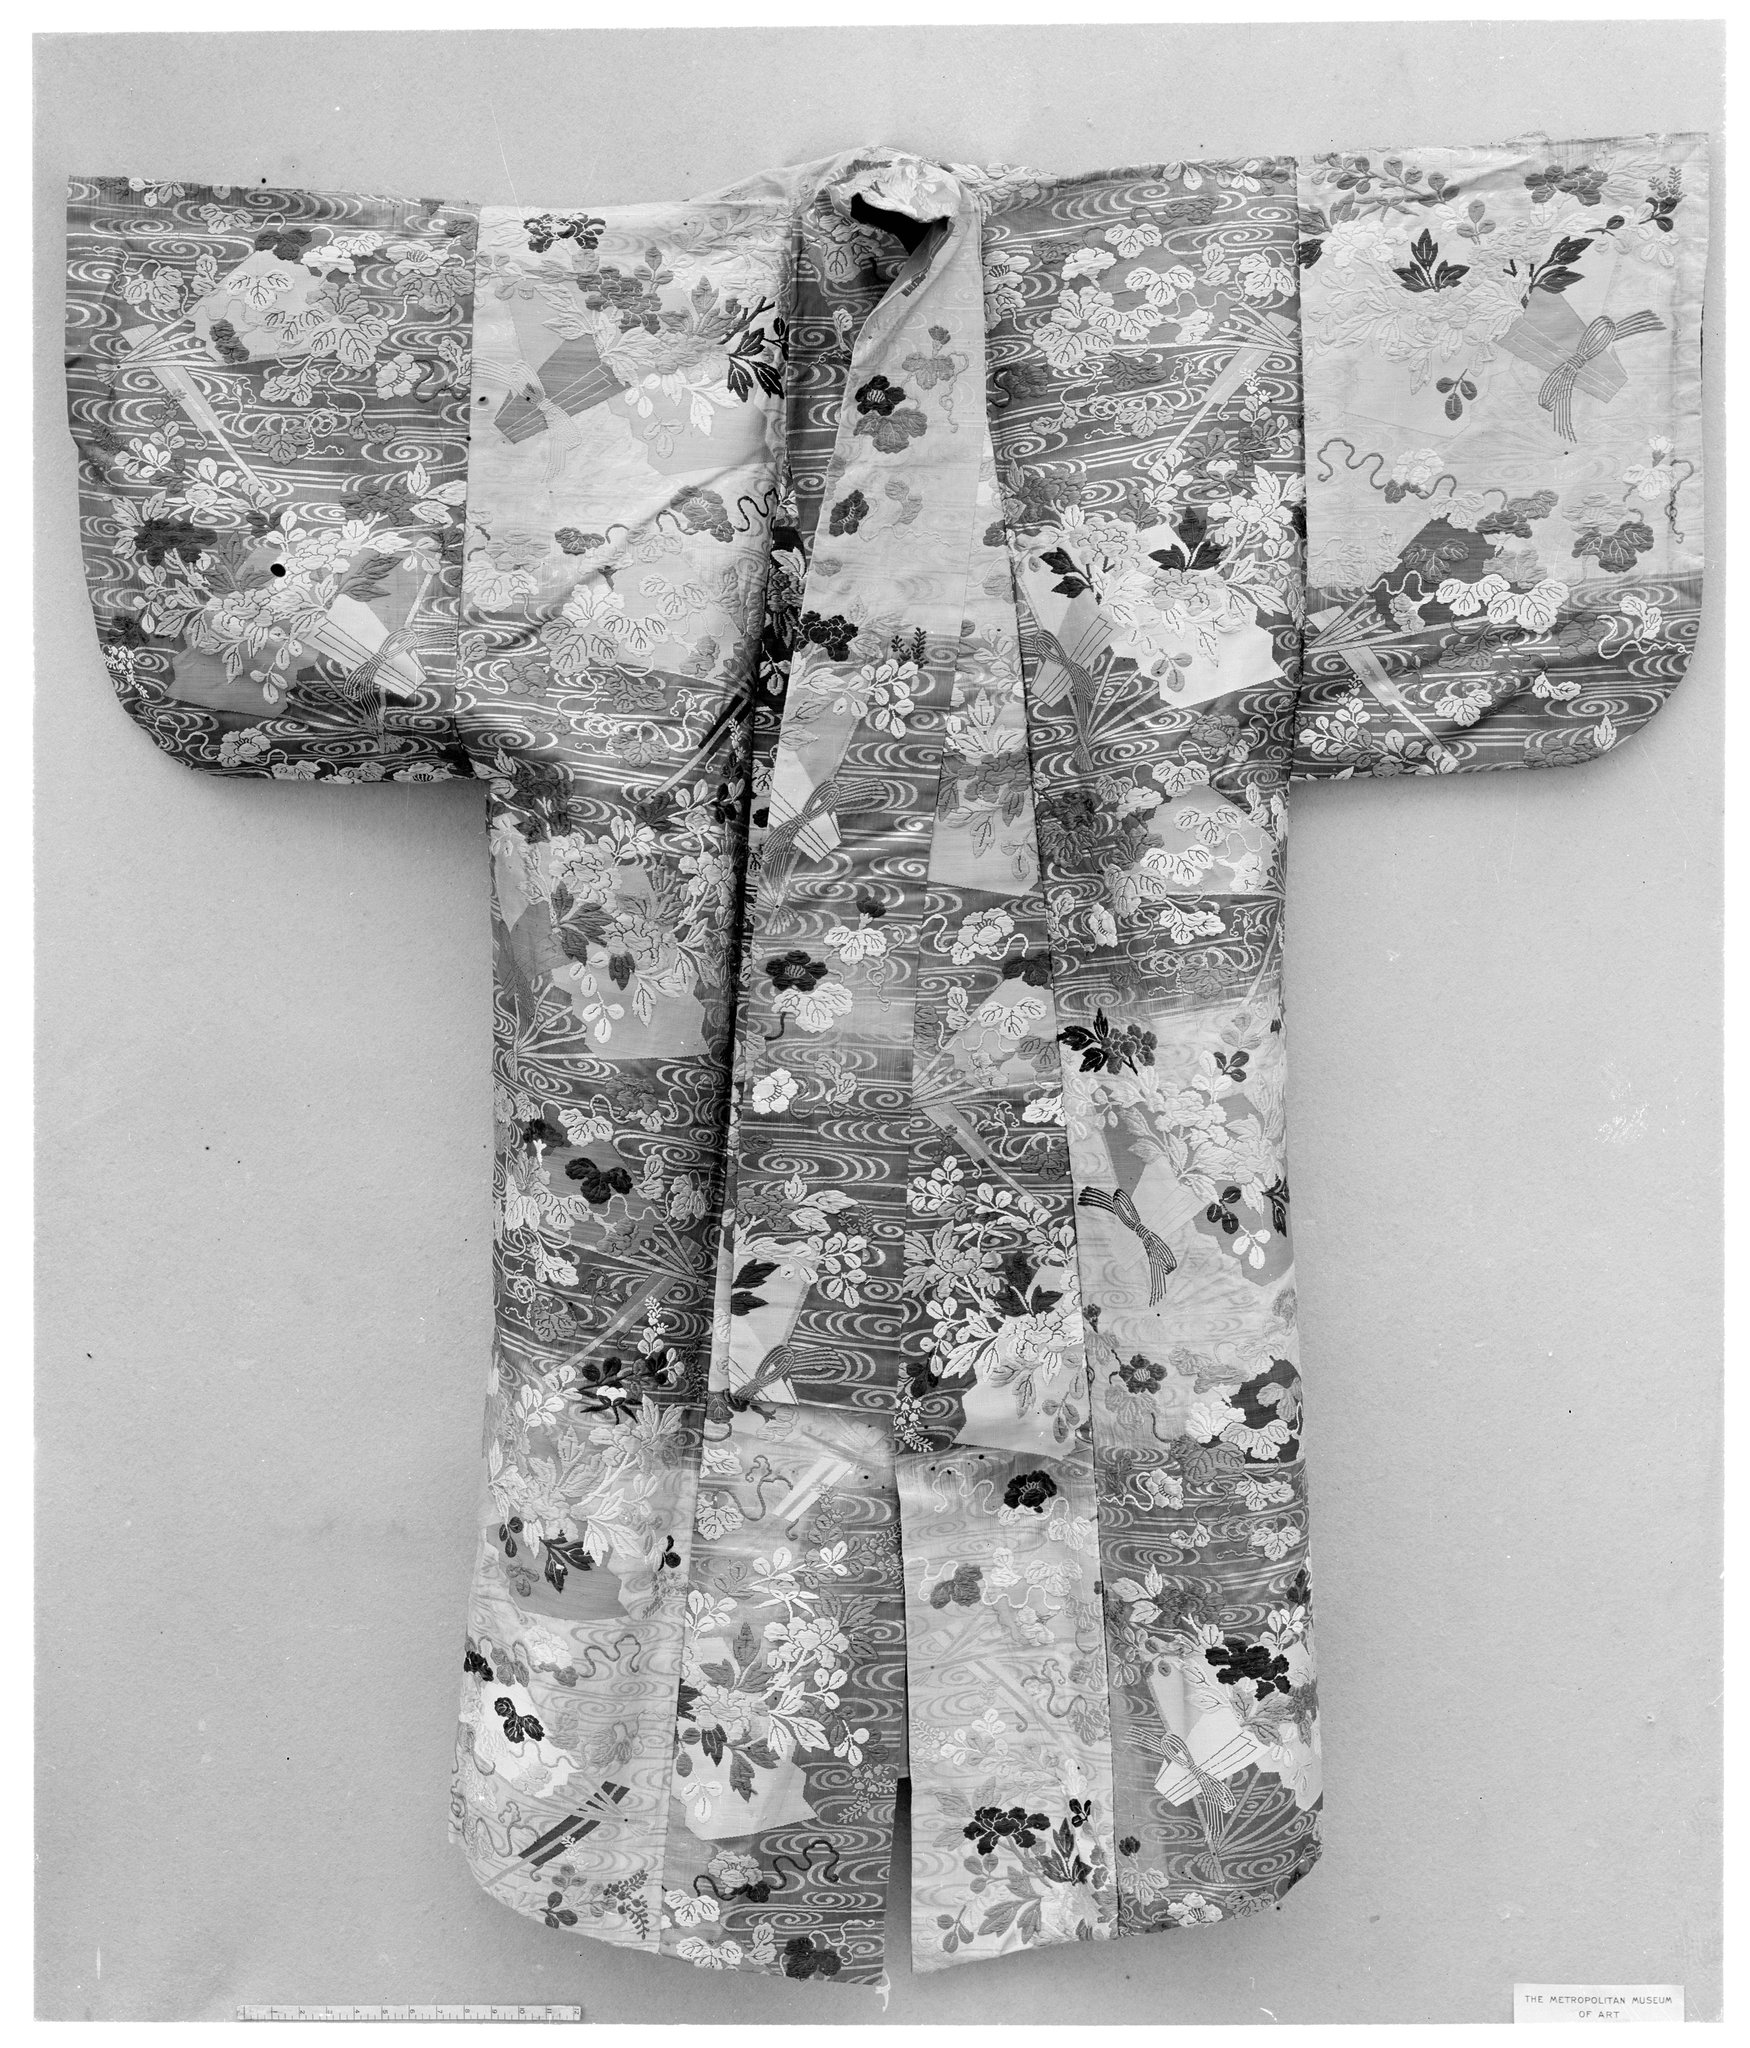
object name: noh costume karaori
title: Noh Costume (Karaori) with Pattern of Fans Floating on Water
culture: japanese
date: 1701-1800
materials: metal thread, silk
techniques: brocade, weave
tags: fans